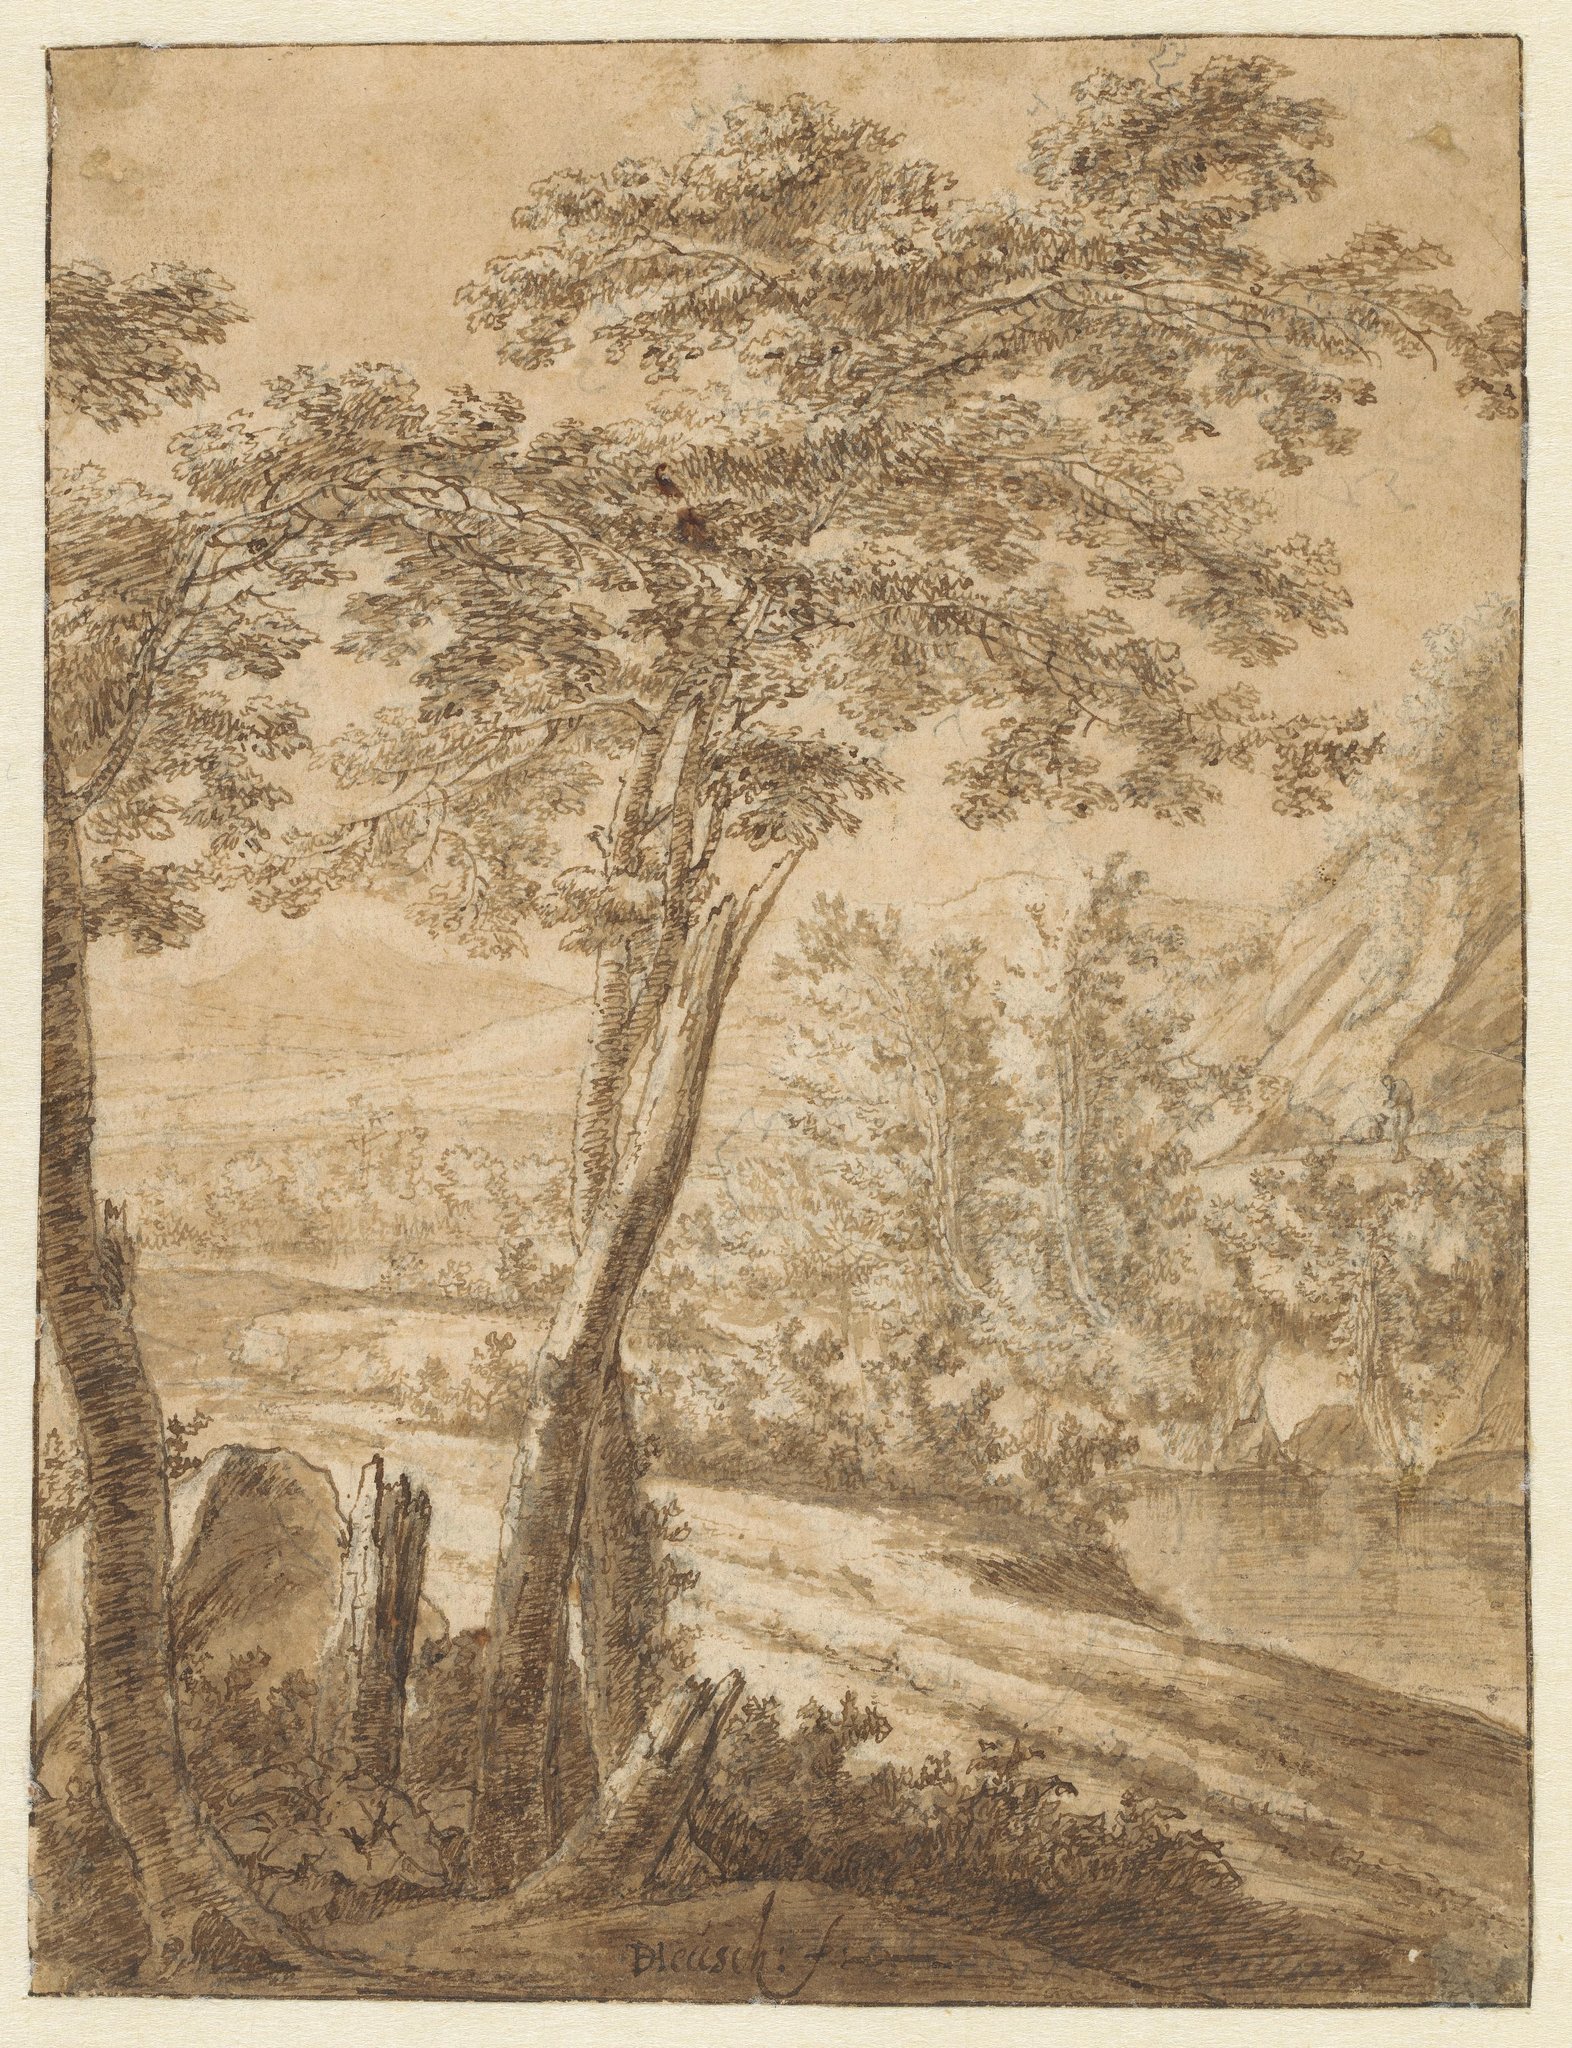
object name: drawing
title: Heuvelachtig landschap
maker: willem de heusch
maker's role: draughtsman, painter, print maker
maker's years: 1625-1692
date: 1635-1692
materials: ink, paper, pencil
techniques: brush, pen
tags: low hill country